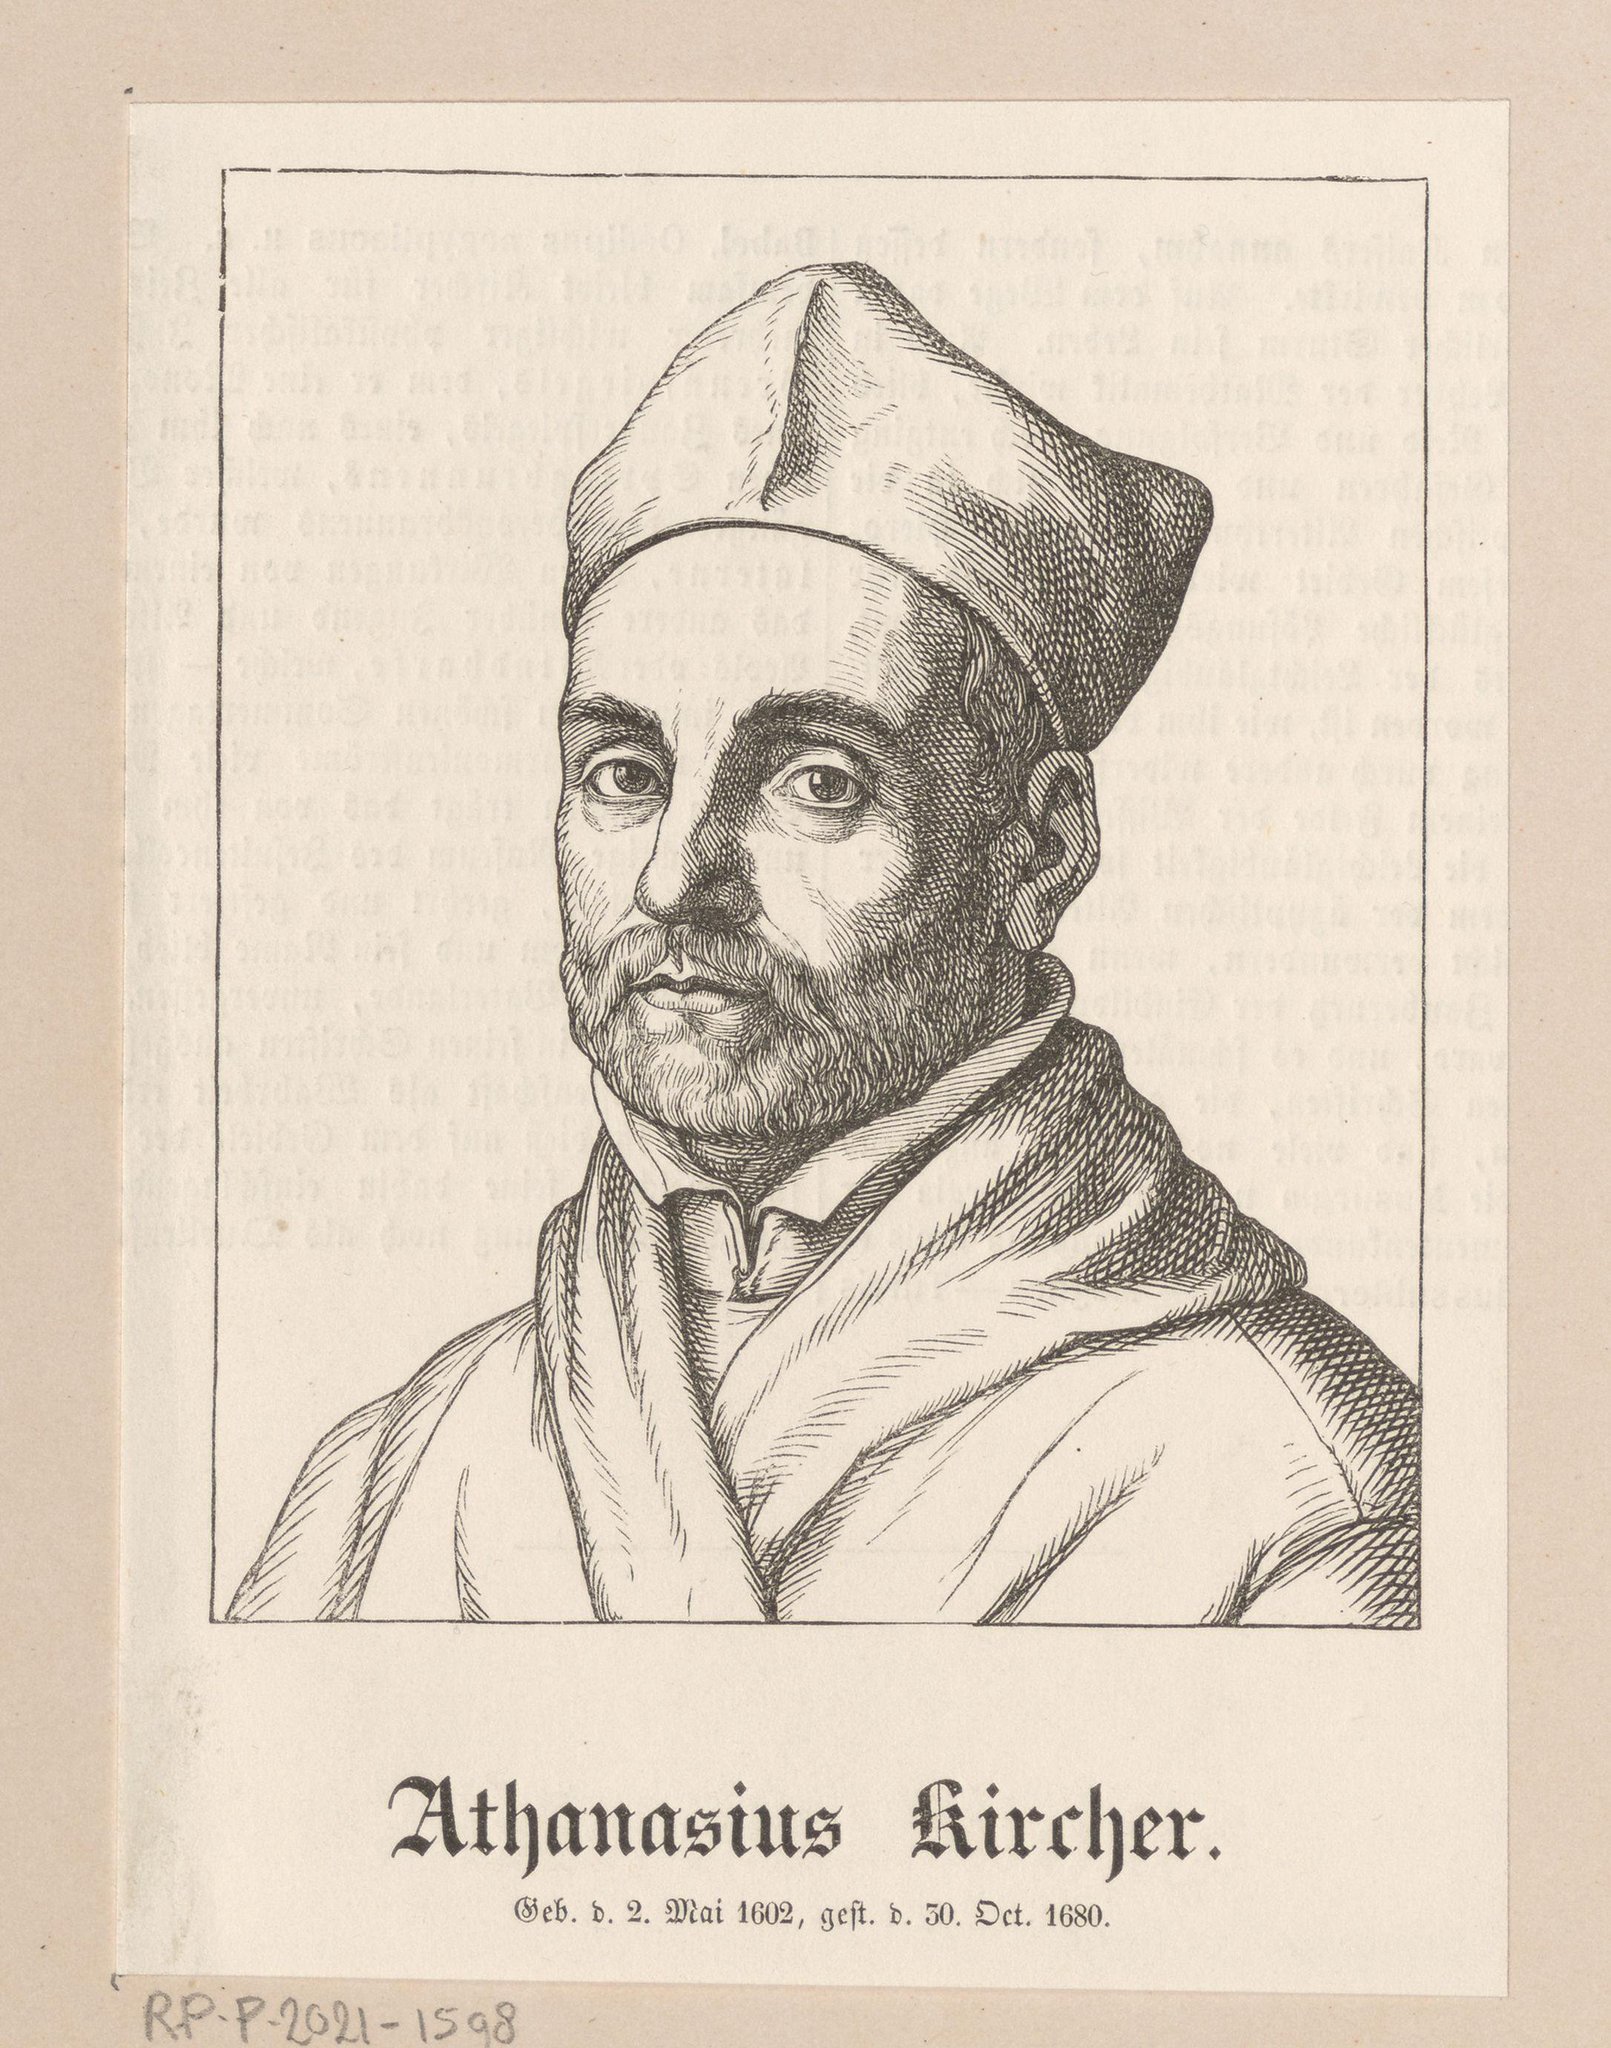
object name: print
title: Portret van Athanasius Kircher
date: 1854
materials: paper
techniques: letterpress printing, engraving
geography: leipzig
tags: rome, historical persons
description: Prent uit: Bechstein, Ludwig. Zweihundert deutsche Männer (...). Leipzig: Georg Wigand, 1854.